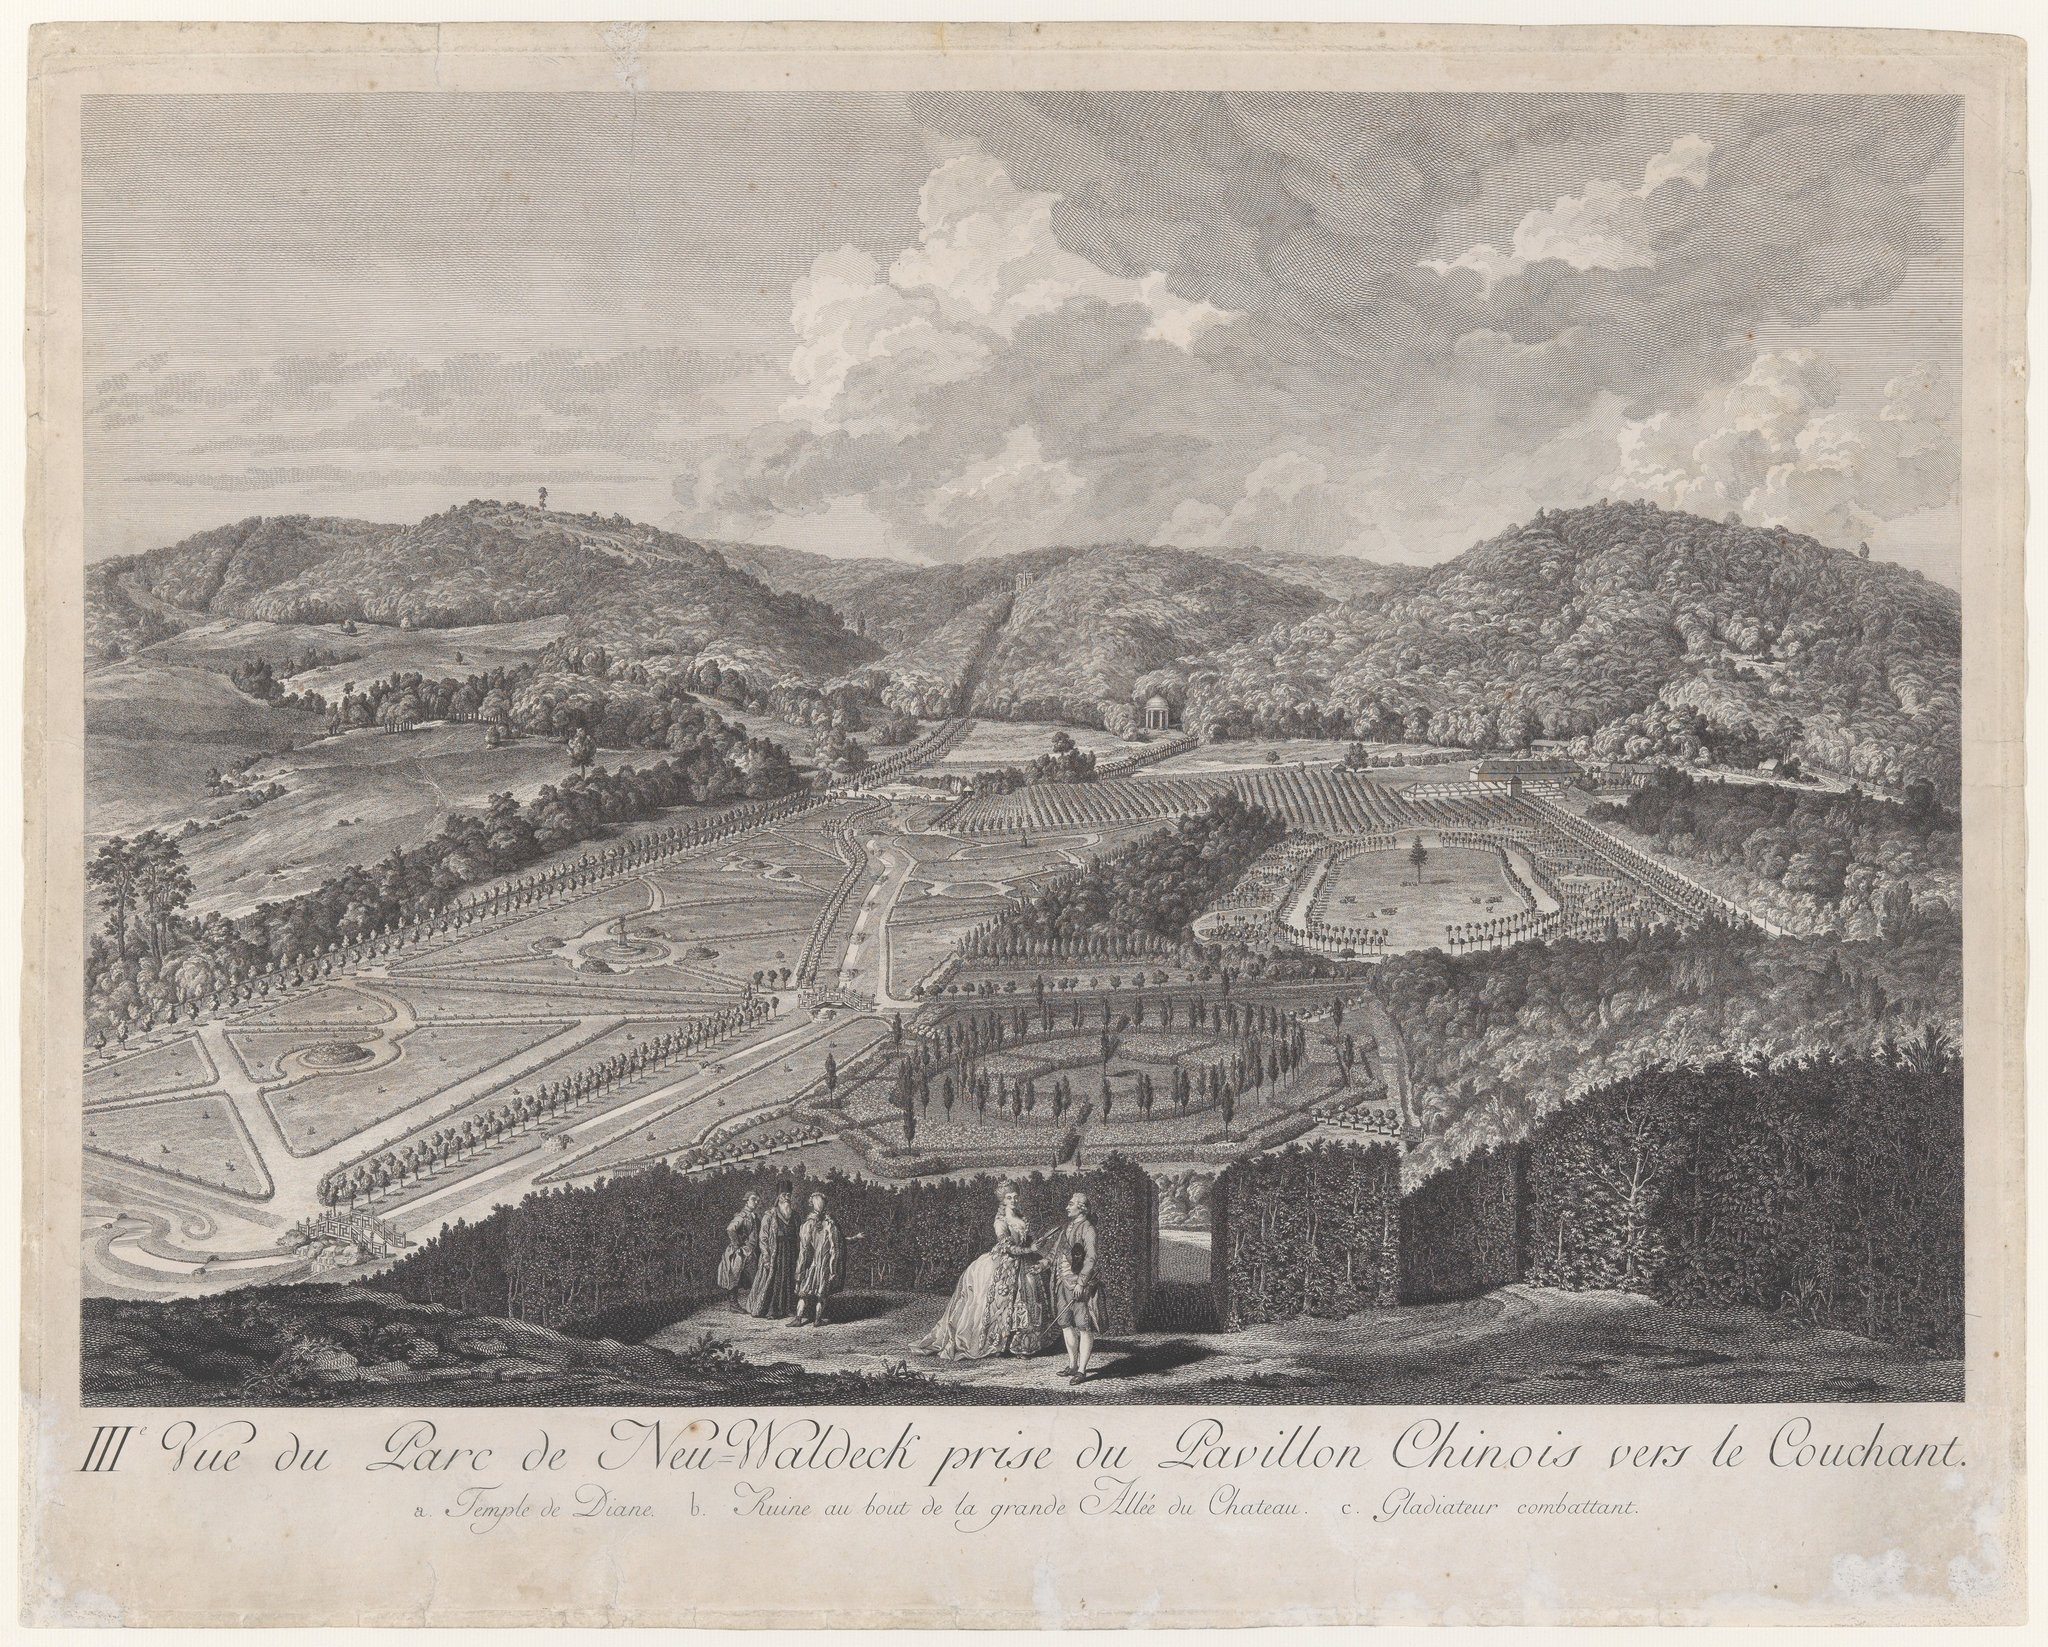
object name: print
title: IIIe Vue du Parc de Neu-Waldeck prise du Pavillon Chinois vers le Couchant, from Views of the Park and Gardens of Marshal Count de Lacy at Neu-waldegg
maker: jakob matthias schmutzer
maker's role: artist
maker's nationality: austrian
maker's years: 1733-1811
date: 1782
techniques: engraving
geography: austria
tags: parks,men,women